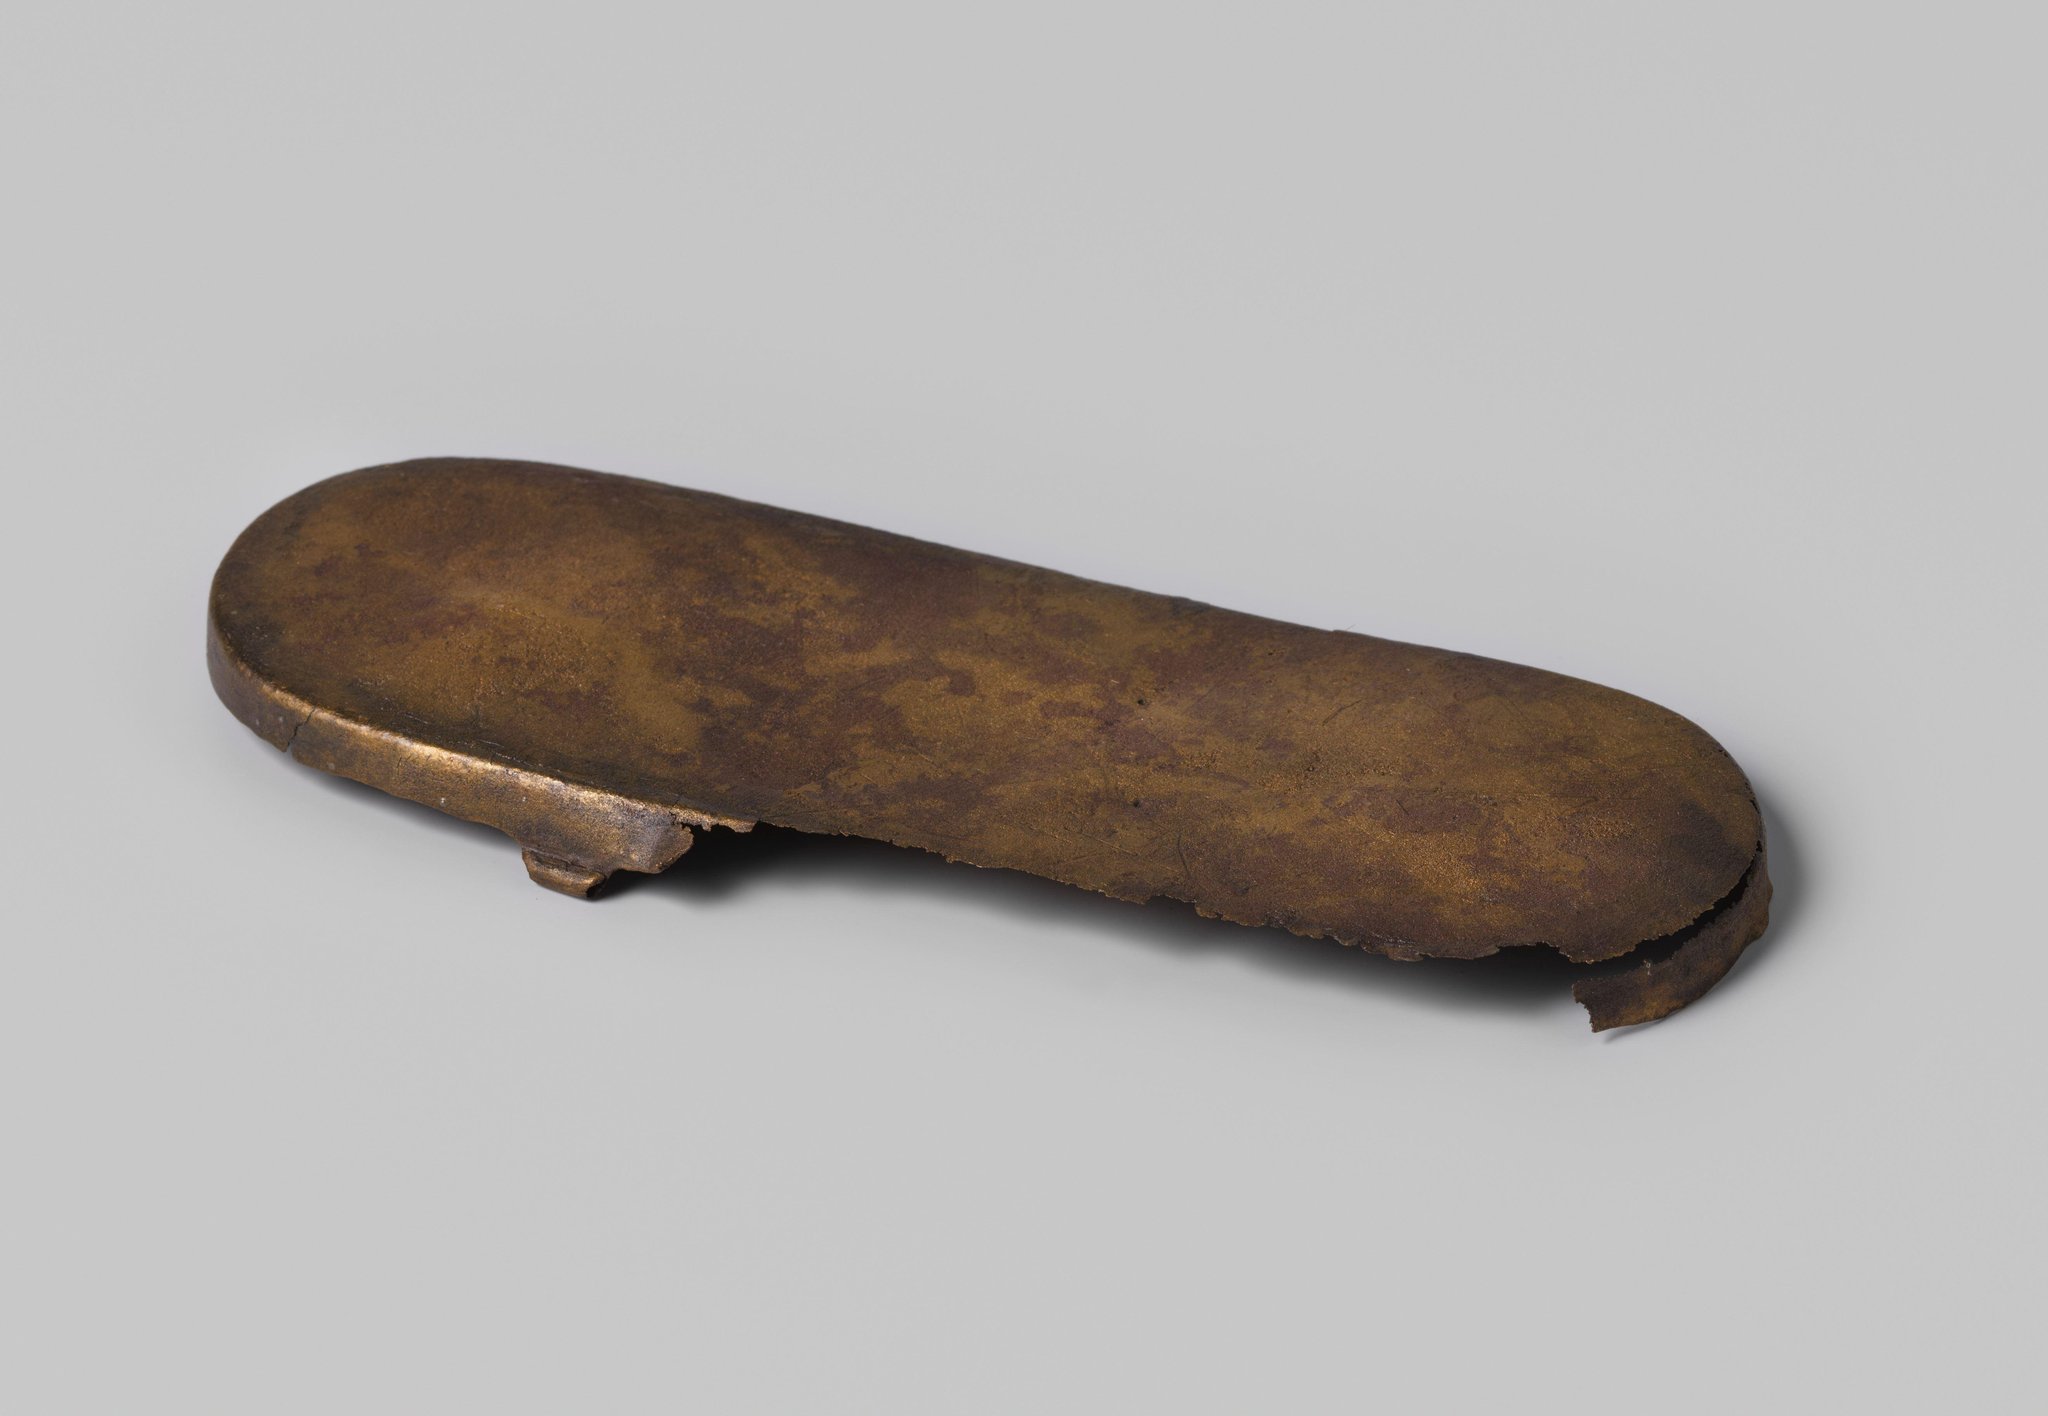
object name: lid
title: Deksel van tabaksdoos uit het wrak van de Oost-Indiëvaarder Hollandia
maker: Anonymous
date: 1700-1743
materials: copper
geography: netherlands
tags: verenigde oostindische compagnie, hollandia (schip), annet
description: Tobacco box; fragm, lid, eroded, oval, plain, hinge damaged, fits to NG 1979-208H937.